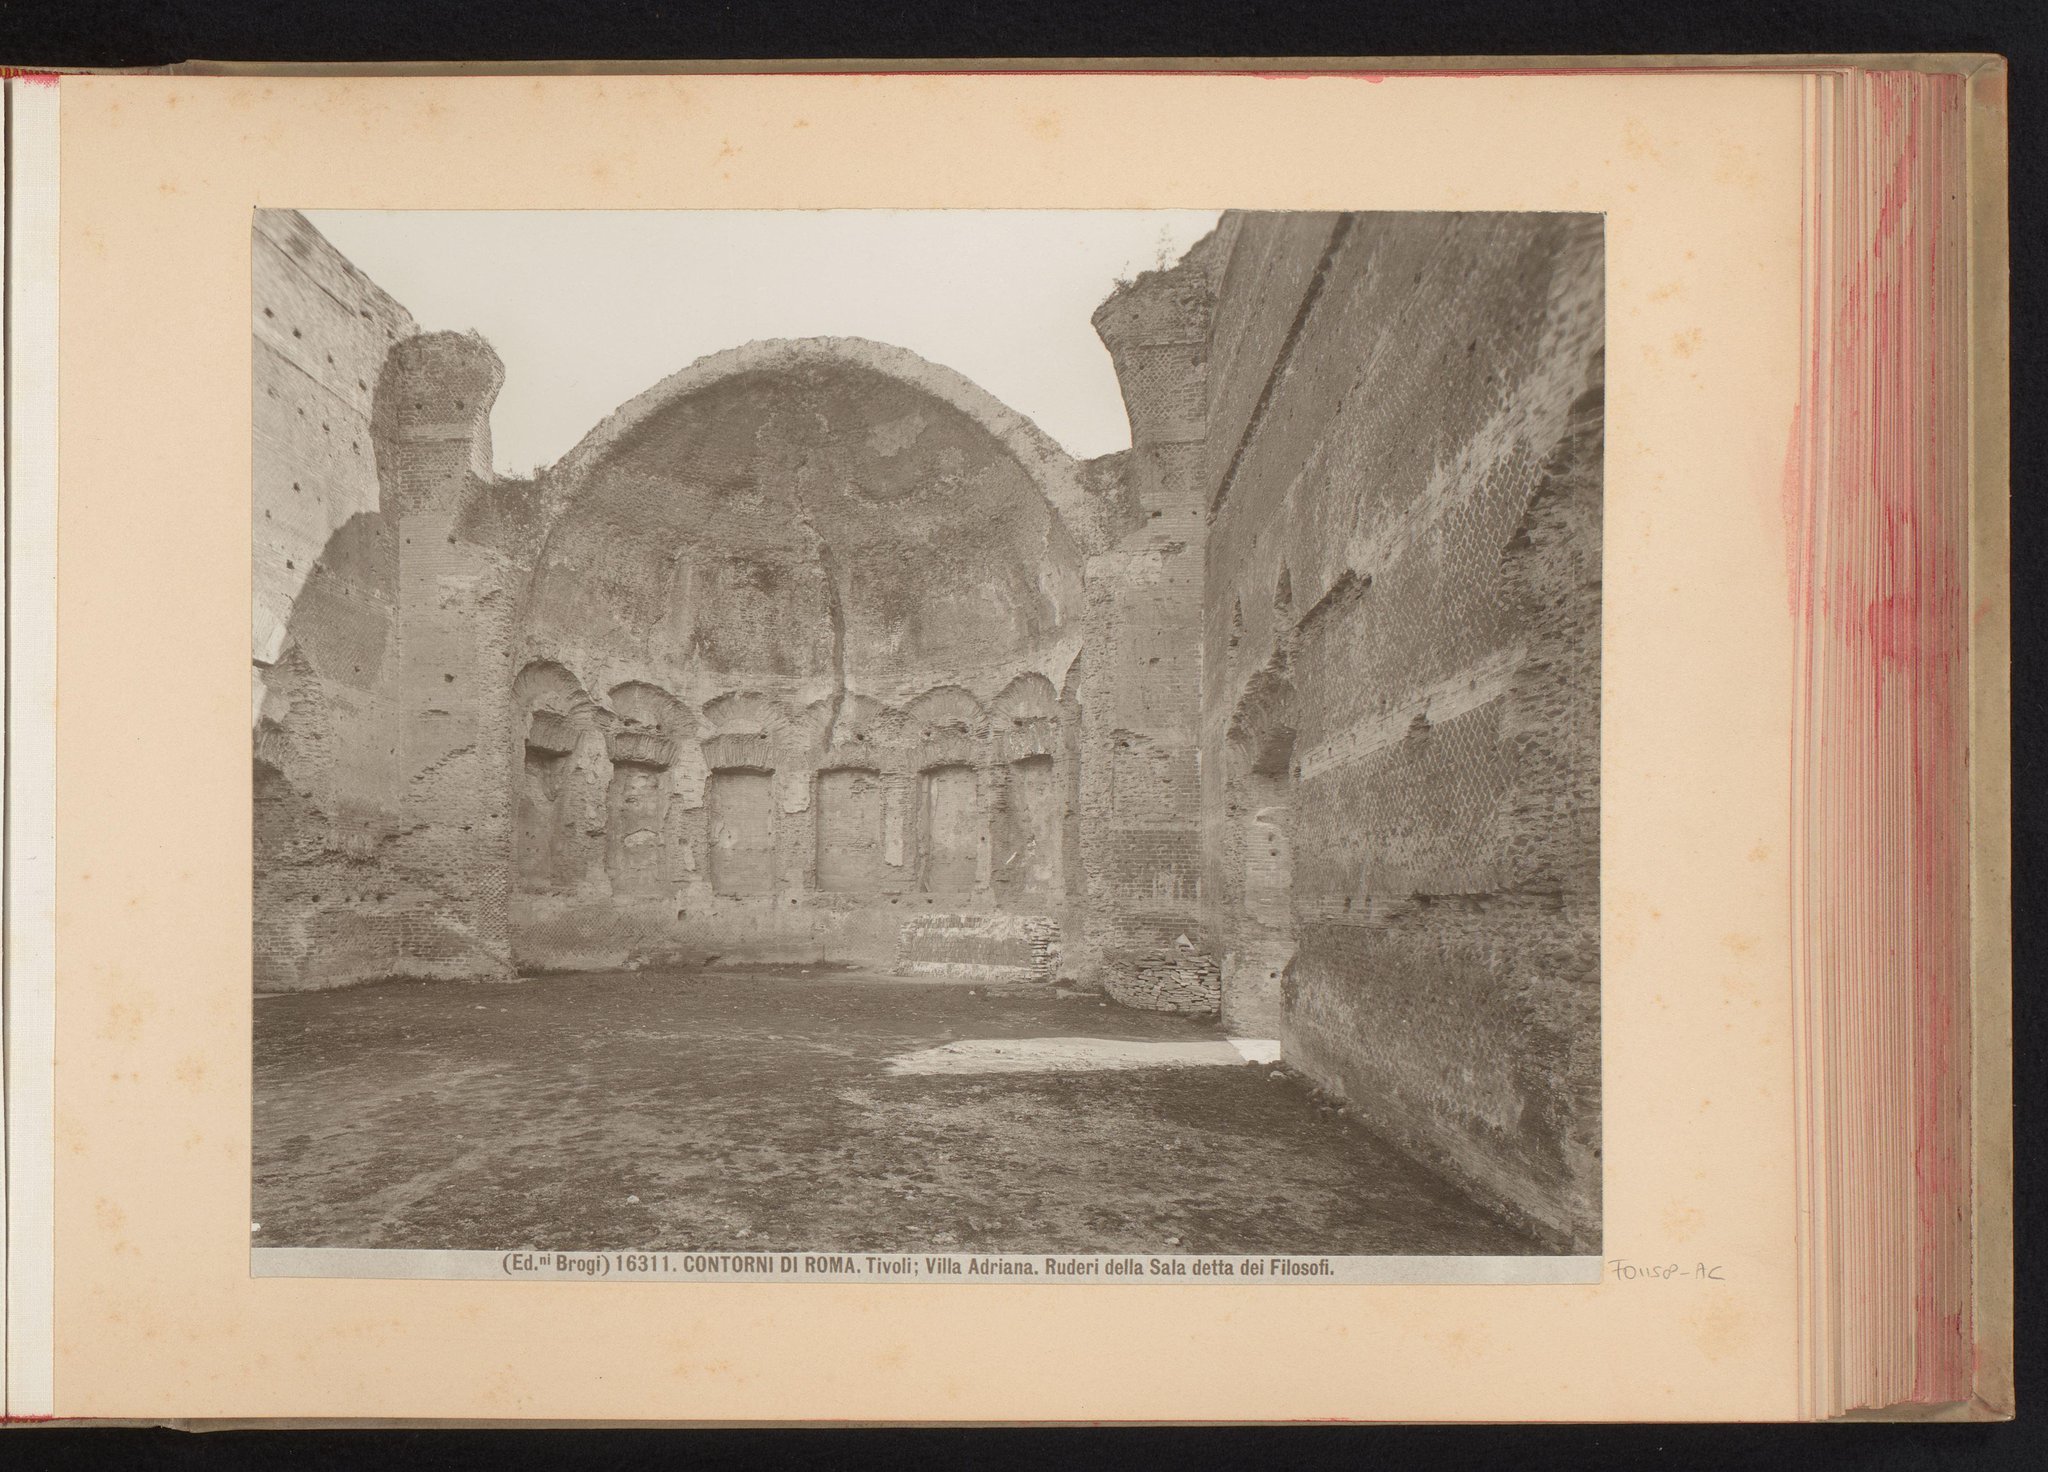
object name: photograph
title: Contorni di Roma. Tivoli; Villa Adriana. Ruderi della Sala detta dei Filosofi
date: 1875-1907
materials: photographic support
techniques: gelatin silver print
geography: tivoli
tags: ruin of a building ~ architecture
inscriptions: number: ‘16311’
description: Onderdeel van Fotoalbum met opnames van bezienswaardigheden en kunstwerken in Italië.